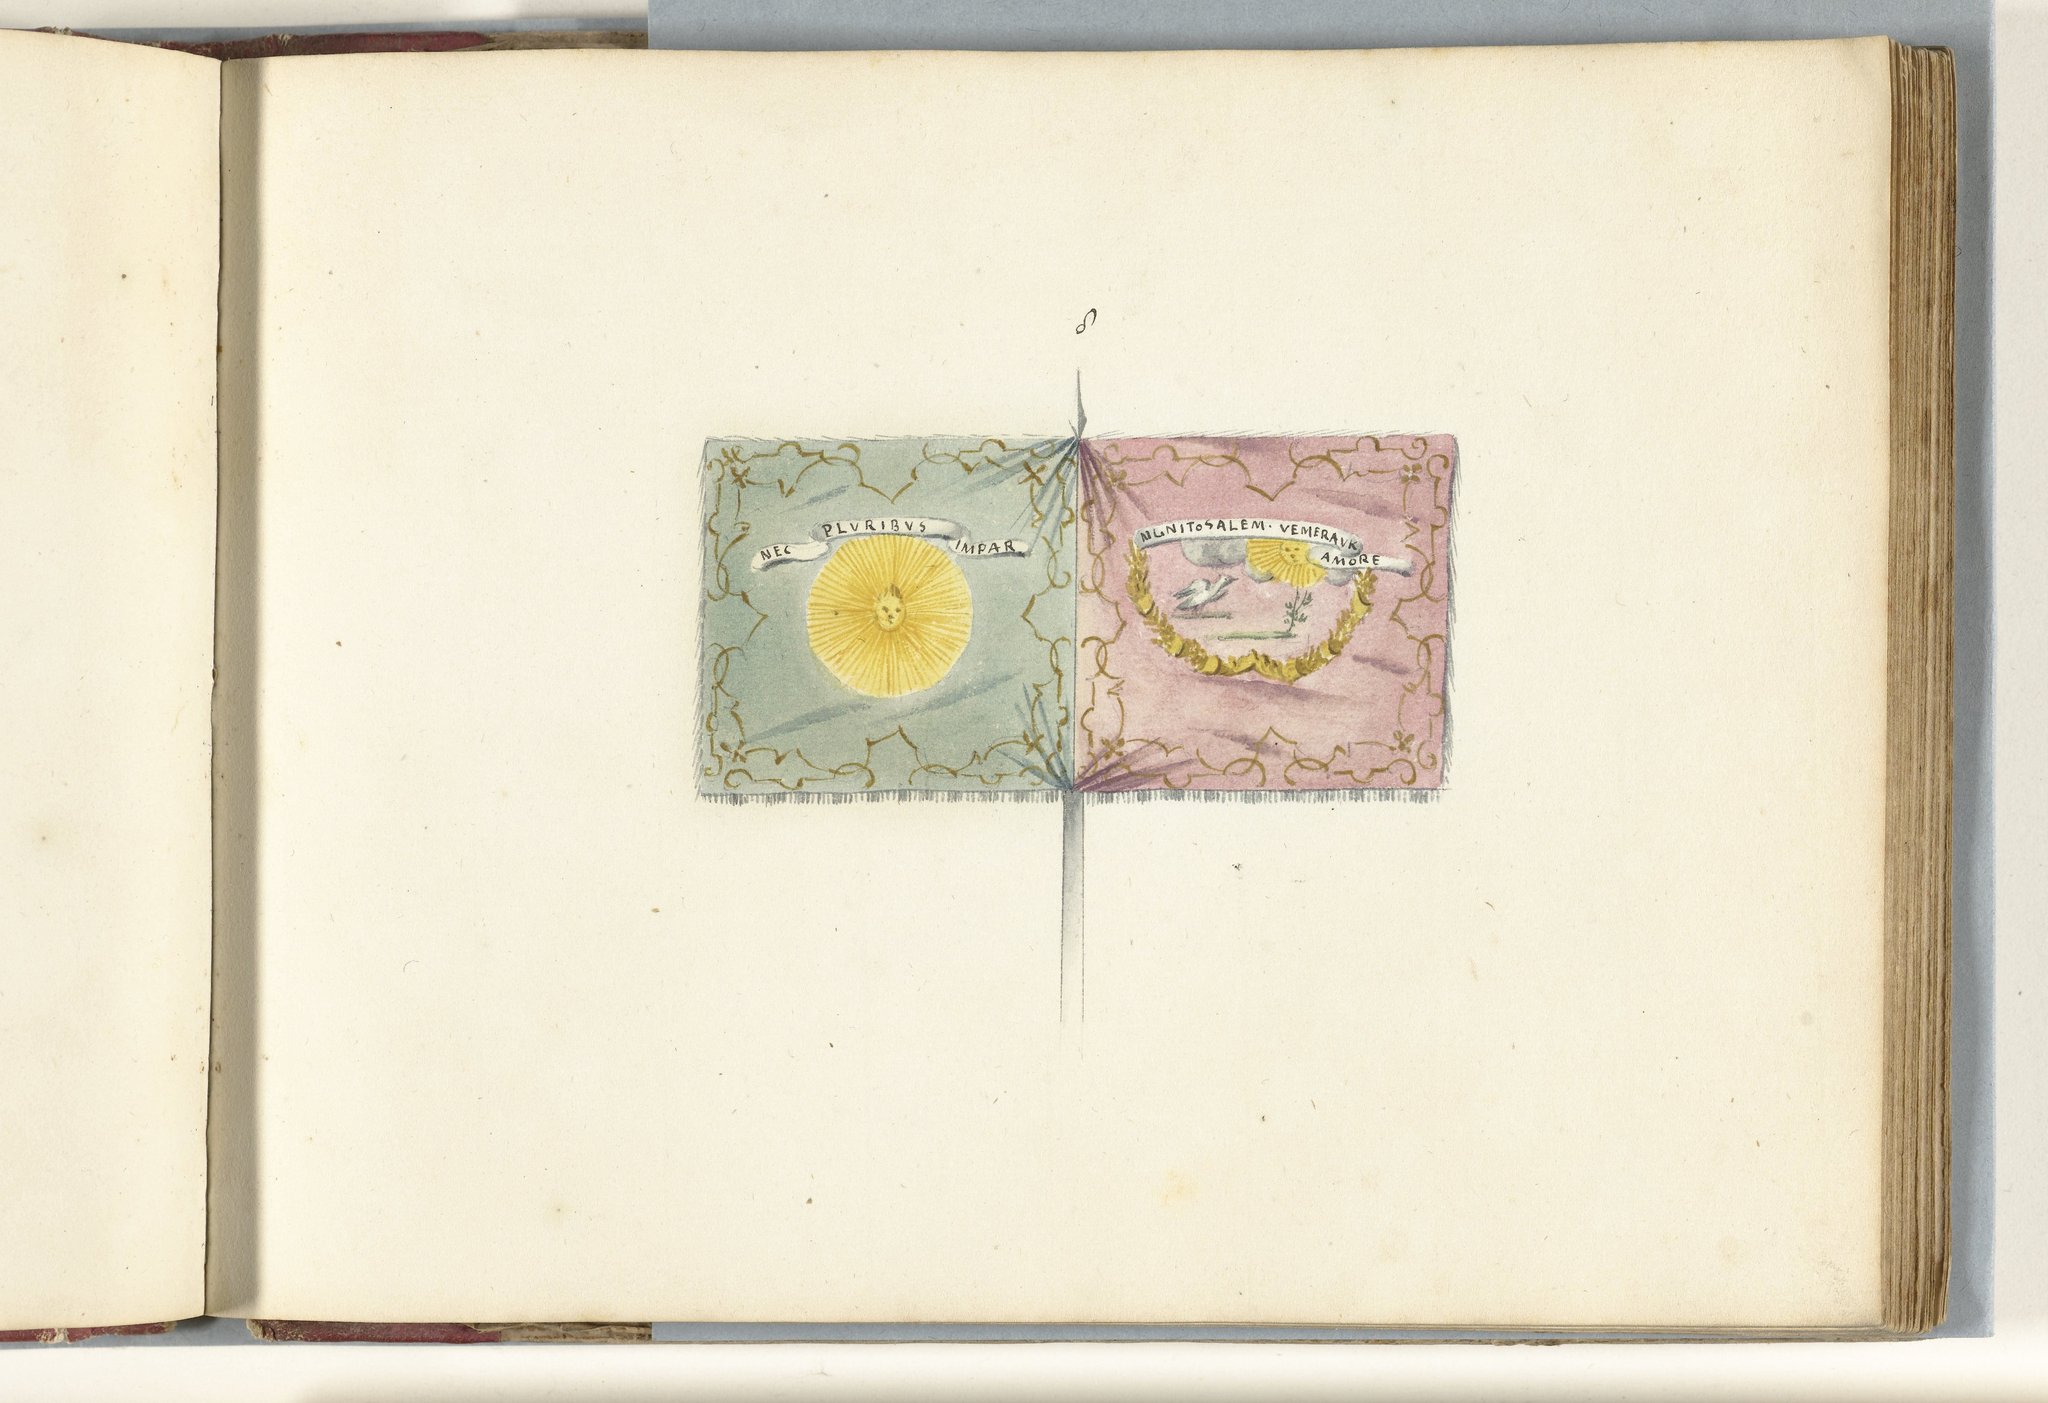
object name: drawing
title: Frans standaard, veroverd in de slag bij Oudenaarde, 1708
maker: Anonymous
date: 1713-1720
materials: paper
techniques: drawing, writing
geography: northern netherlands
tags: (military) flags and standards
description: Een Frans standaard, veroverd bij de slag bij Oudenaarde in 1708. In het boek met tekeningen van Franse vaandels, standaarden en pauken, veroverd tijdens de Spaanse Successieoorlog (1701-1713).